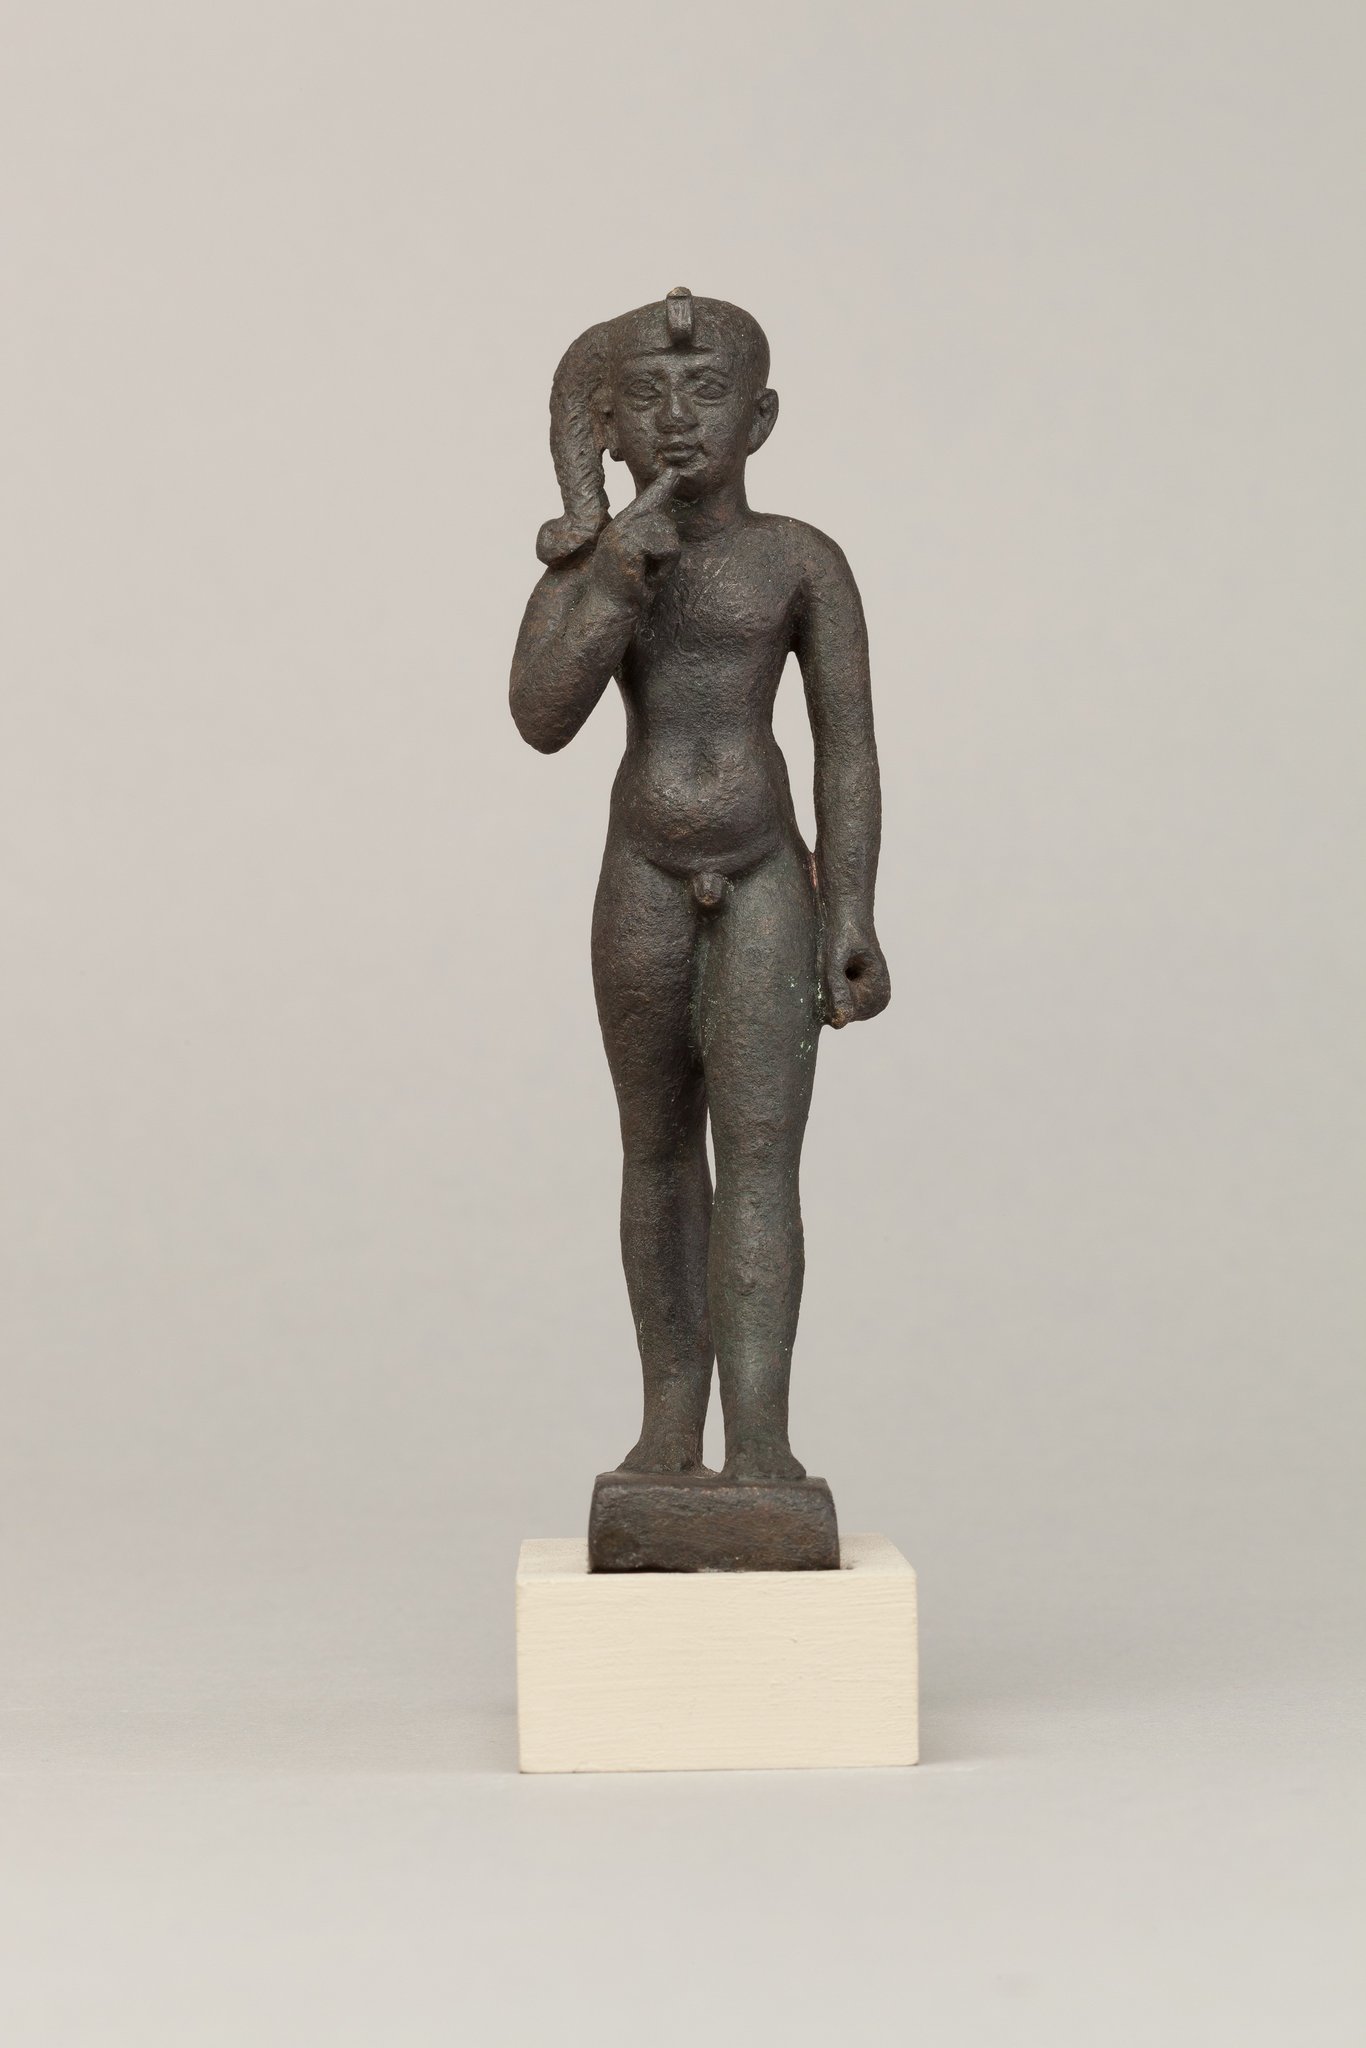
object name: statuette, child god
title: Statuette of a child god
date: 664-630 BCE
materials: metal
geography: egypt